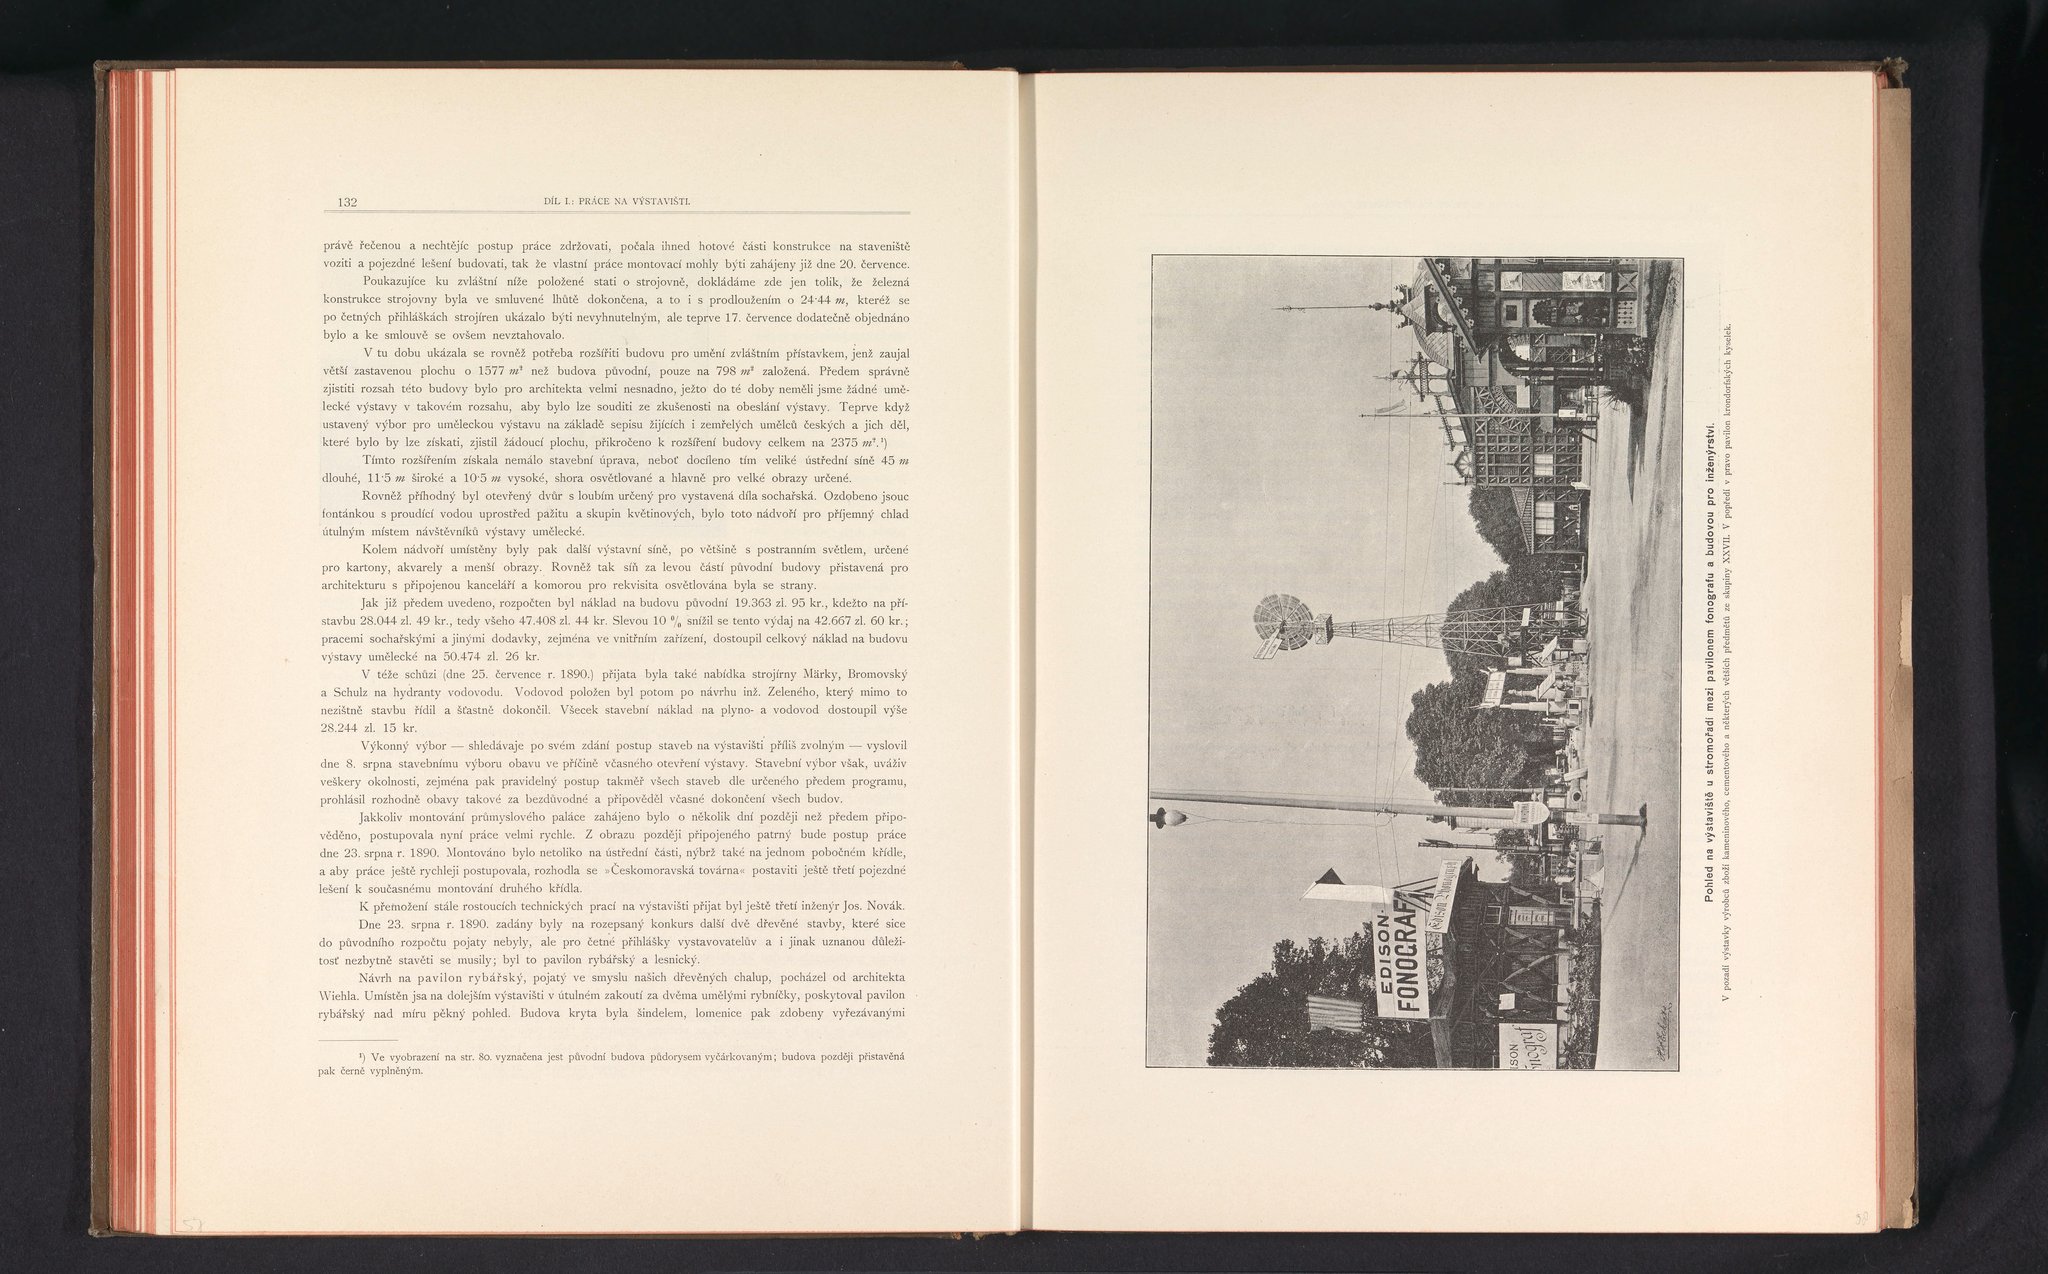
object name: photomechanical print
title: Gezicht op het Výstaviště te Praag met een gebouw voor fonografen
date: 1888-1893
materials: paper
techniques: autotype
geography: výstaviště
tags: façade (of house or building), temporary exhibition, 'salon'